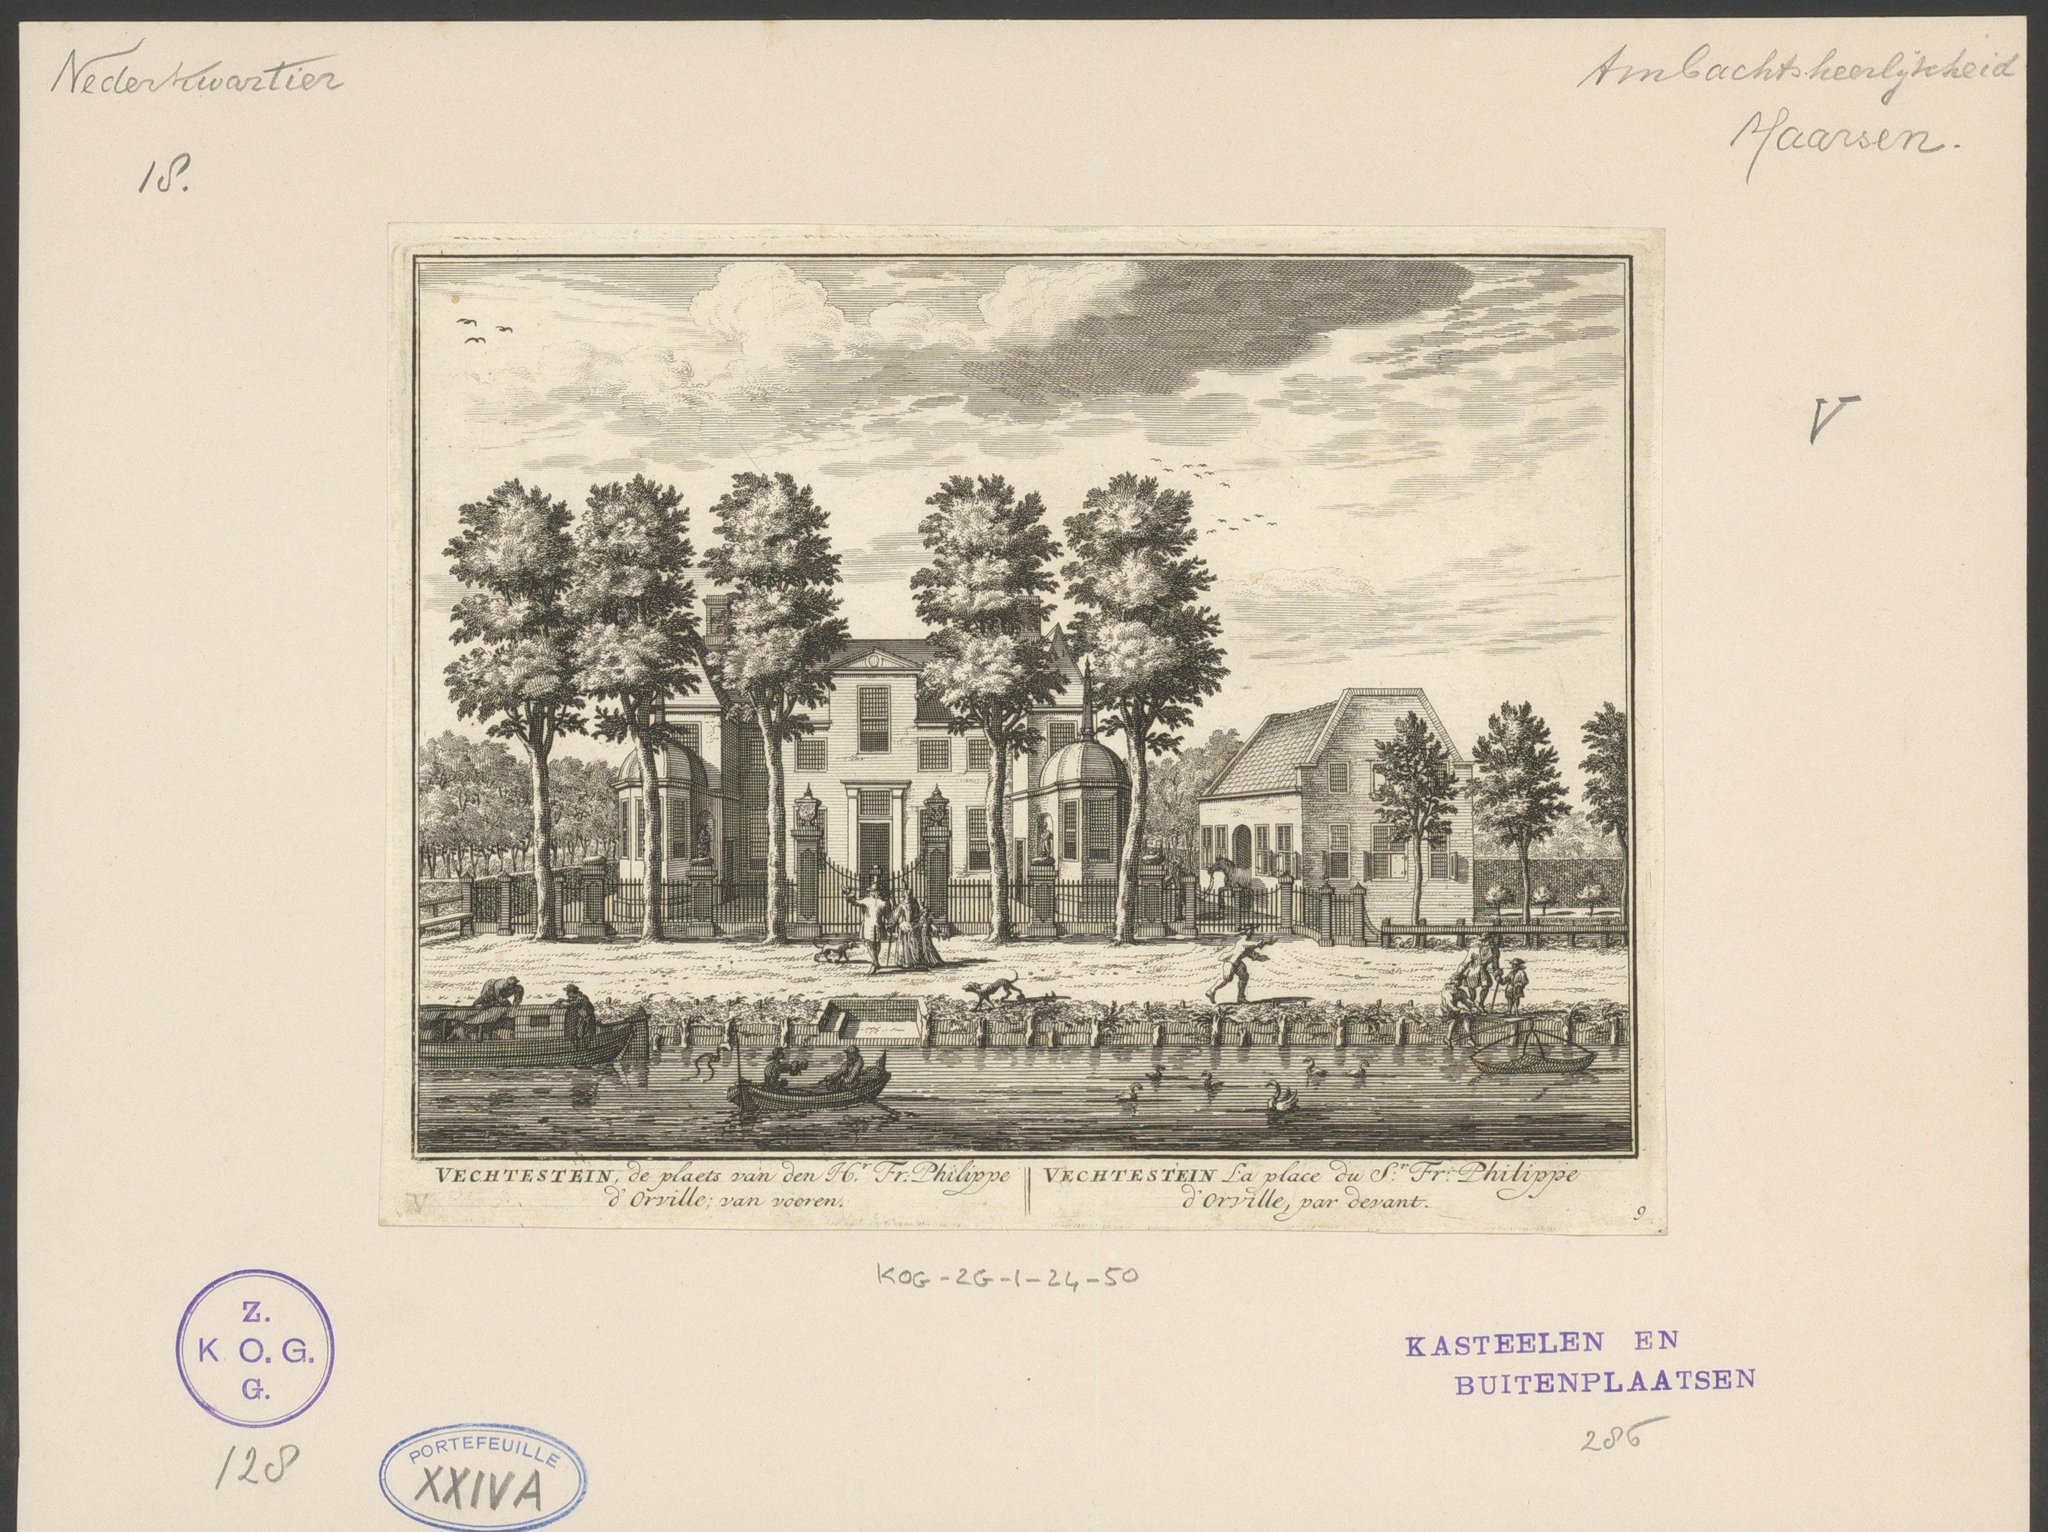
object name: print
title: Gezicht op de buitenplaats Vechtenstein aan de Vecht nabij Maarssen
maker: daniël stopendaal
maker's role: print maker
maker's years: 1672-1726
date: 1719-1790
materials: paper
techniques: engraving, etching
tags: river (+ landscape with figures, staffage), country-house, maarssen, vecht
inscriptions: stamp, collector's mark: Lugt 1641, stamp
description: Prent mogelijk uit: Stopendaal, Daniël. De zegepraalende Vecht, vertoonende verscheidenen gesichten van lustplaatsen, heeren huysen en dorpen, beginnende van Uitrecht en met Muyden besluytende. Amsterdam: Weduwe Nicolaas Visscher, 1719. Of uit: De Vechtstroom van Utrecht tot Muiden verheerlykt door honderd gezichten (...). Amsterdam: Andries de Leth en Matthaeus Brouerius van Nidek, 1790.